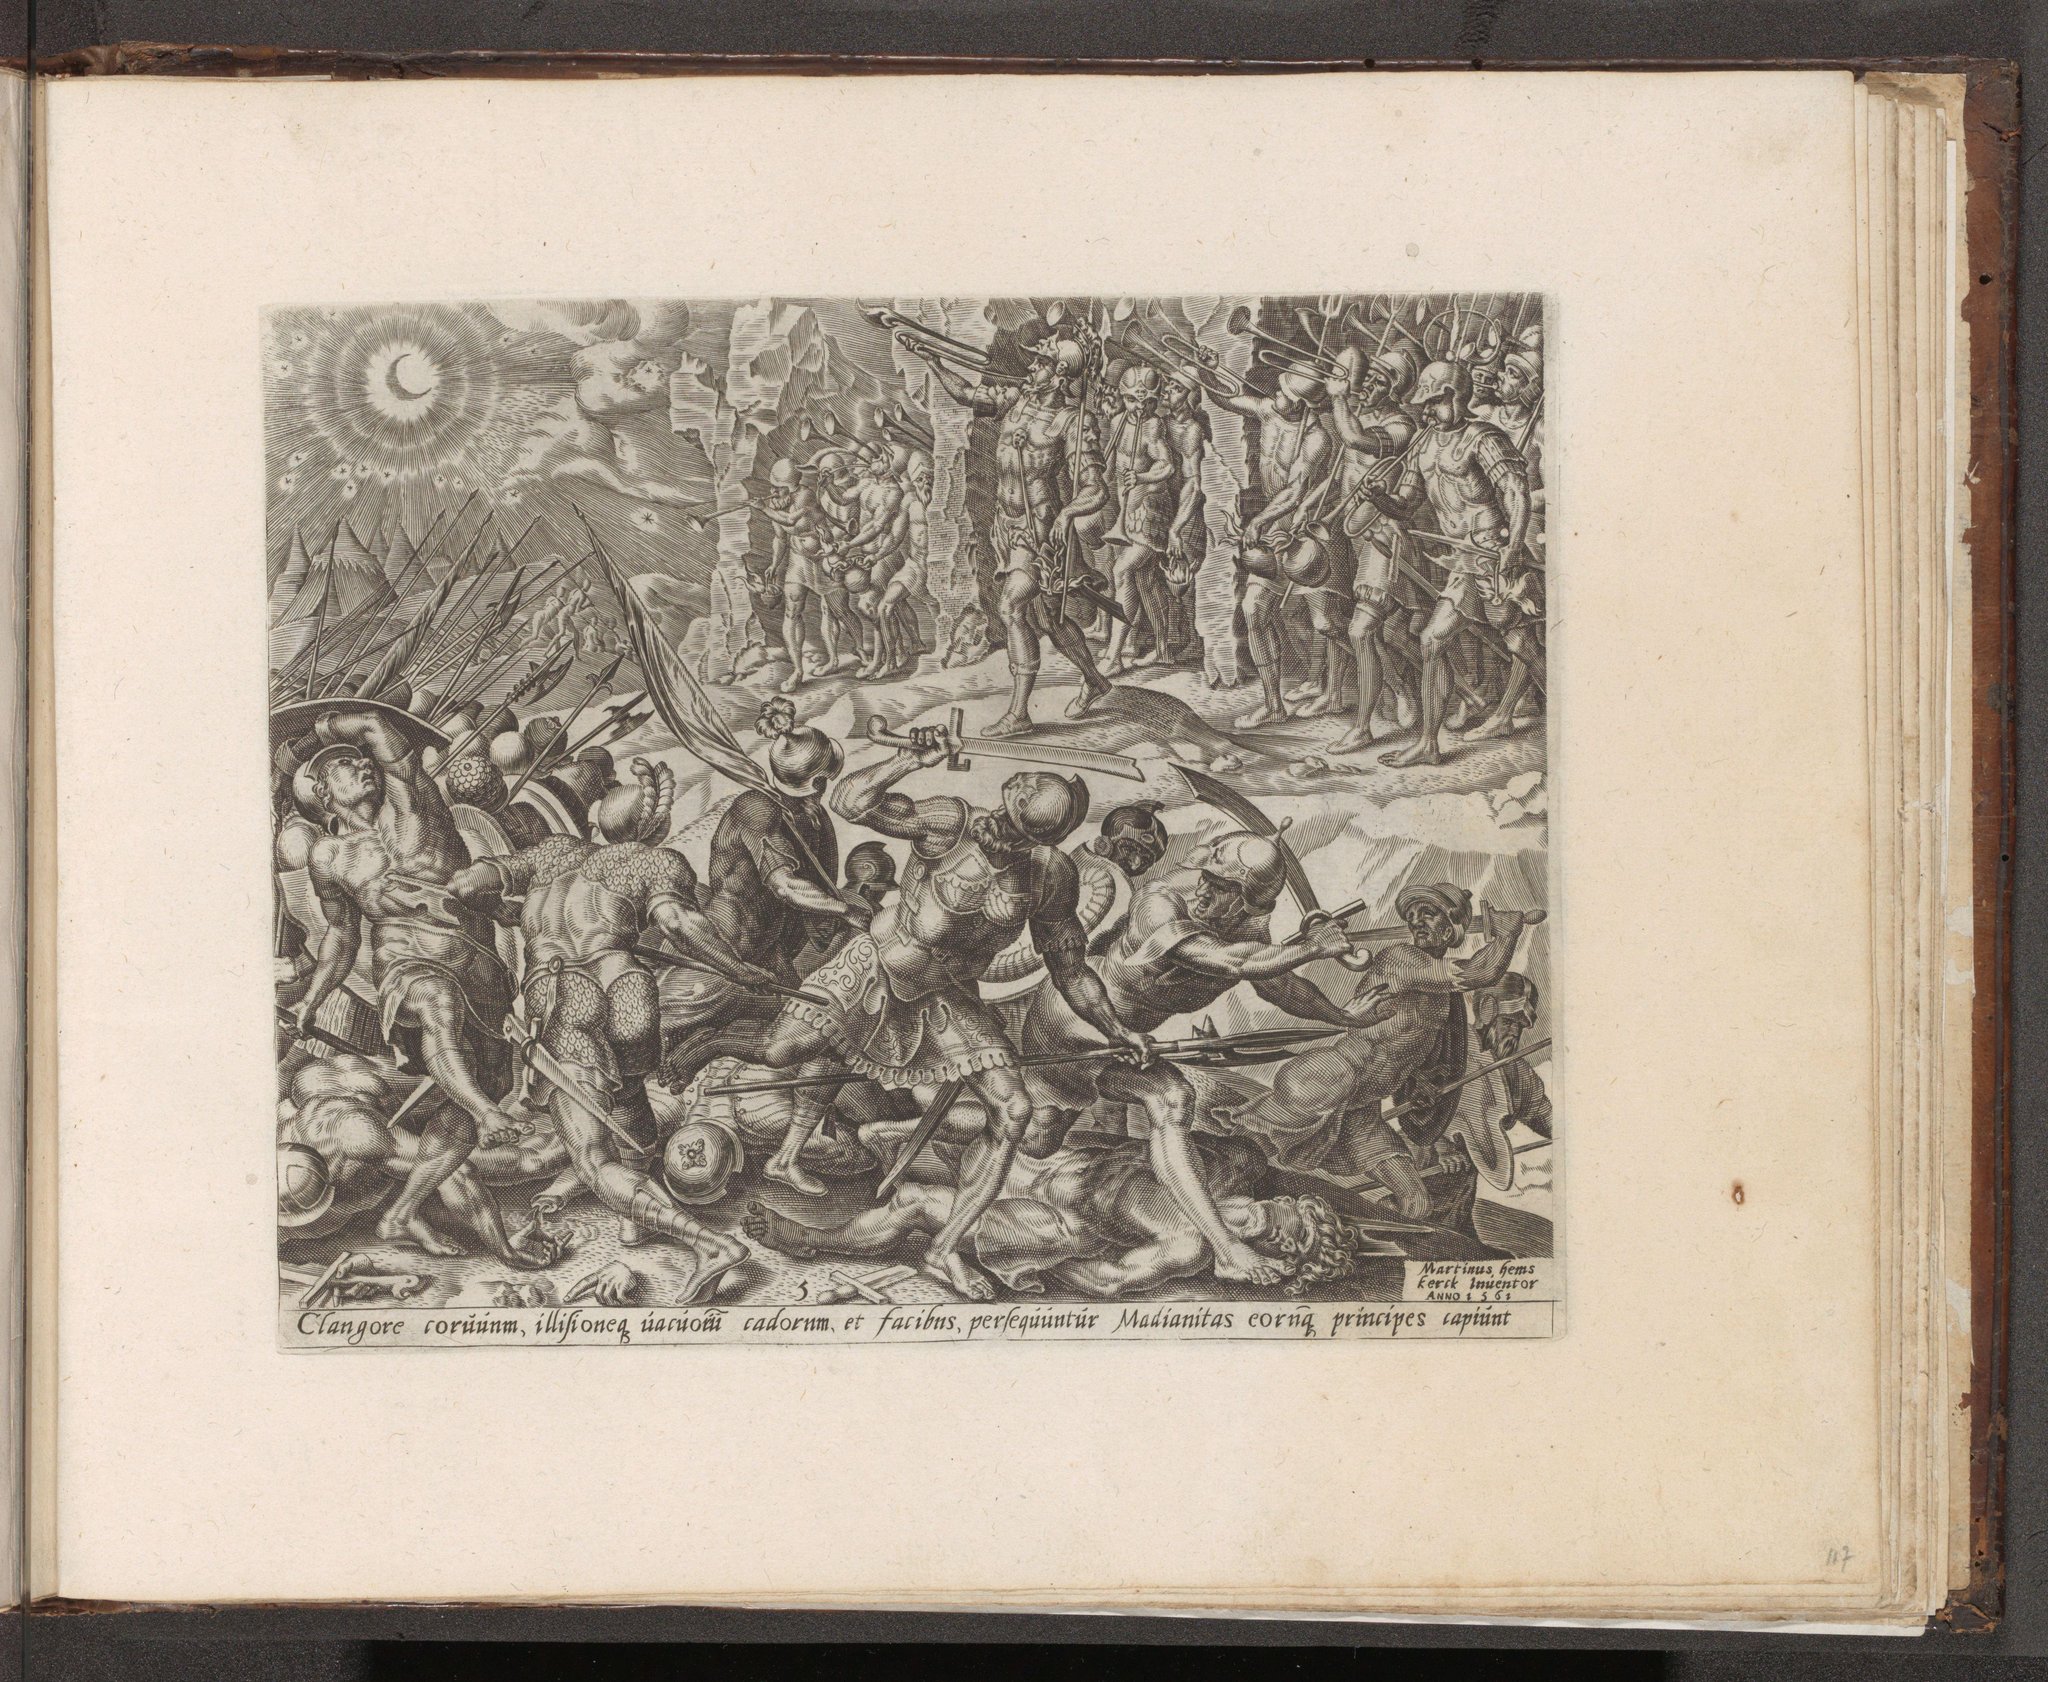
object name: album leaf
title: Gideon valt de Midjanieten aan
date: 1561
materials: paper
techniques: engraving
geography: antwerp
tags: flight of the midianites, the attack on the midianites: gideon and his men blow their trumpets, break their pitchers, and hold their lamps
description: Op de achtergrond blazen Gideon en zijn manschappen op hun trompetten rond het kamp van de Midjanieten. In hun hand hebben ze een lege waterkruik met een brandende fakkel erin, die ze later op de grond gooien. Vooraan nemen de Midjanieten het tegen elkaar op. Linksachter het tentenkamp bij maanlicht. Onder de voorstelling een onderschrift in het Latijn. Prent maakt deel uit van een album.